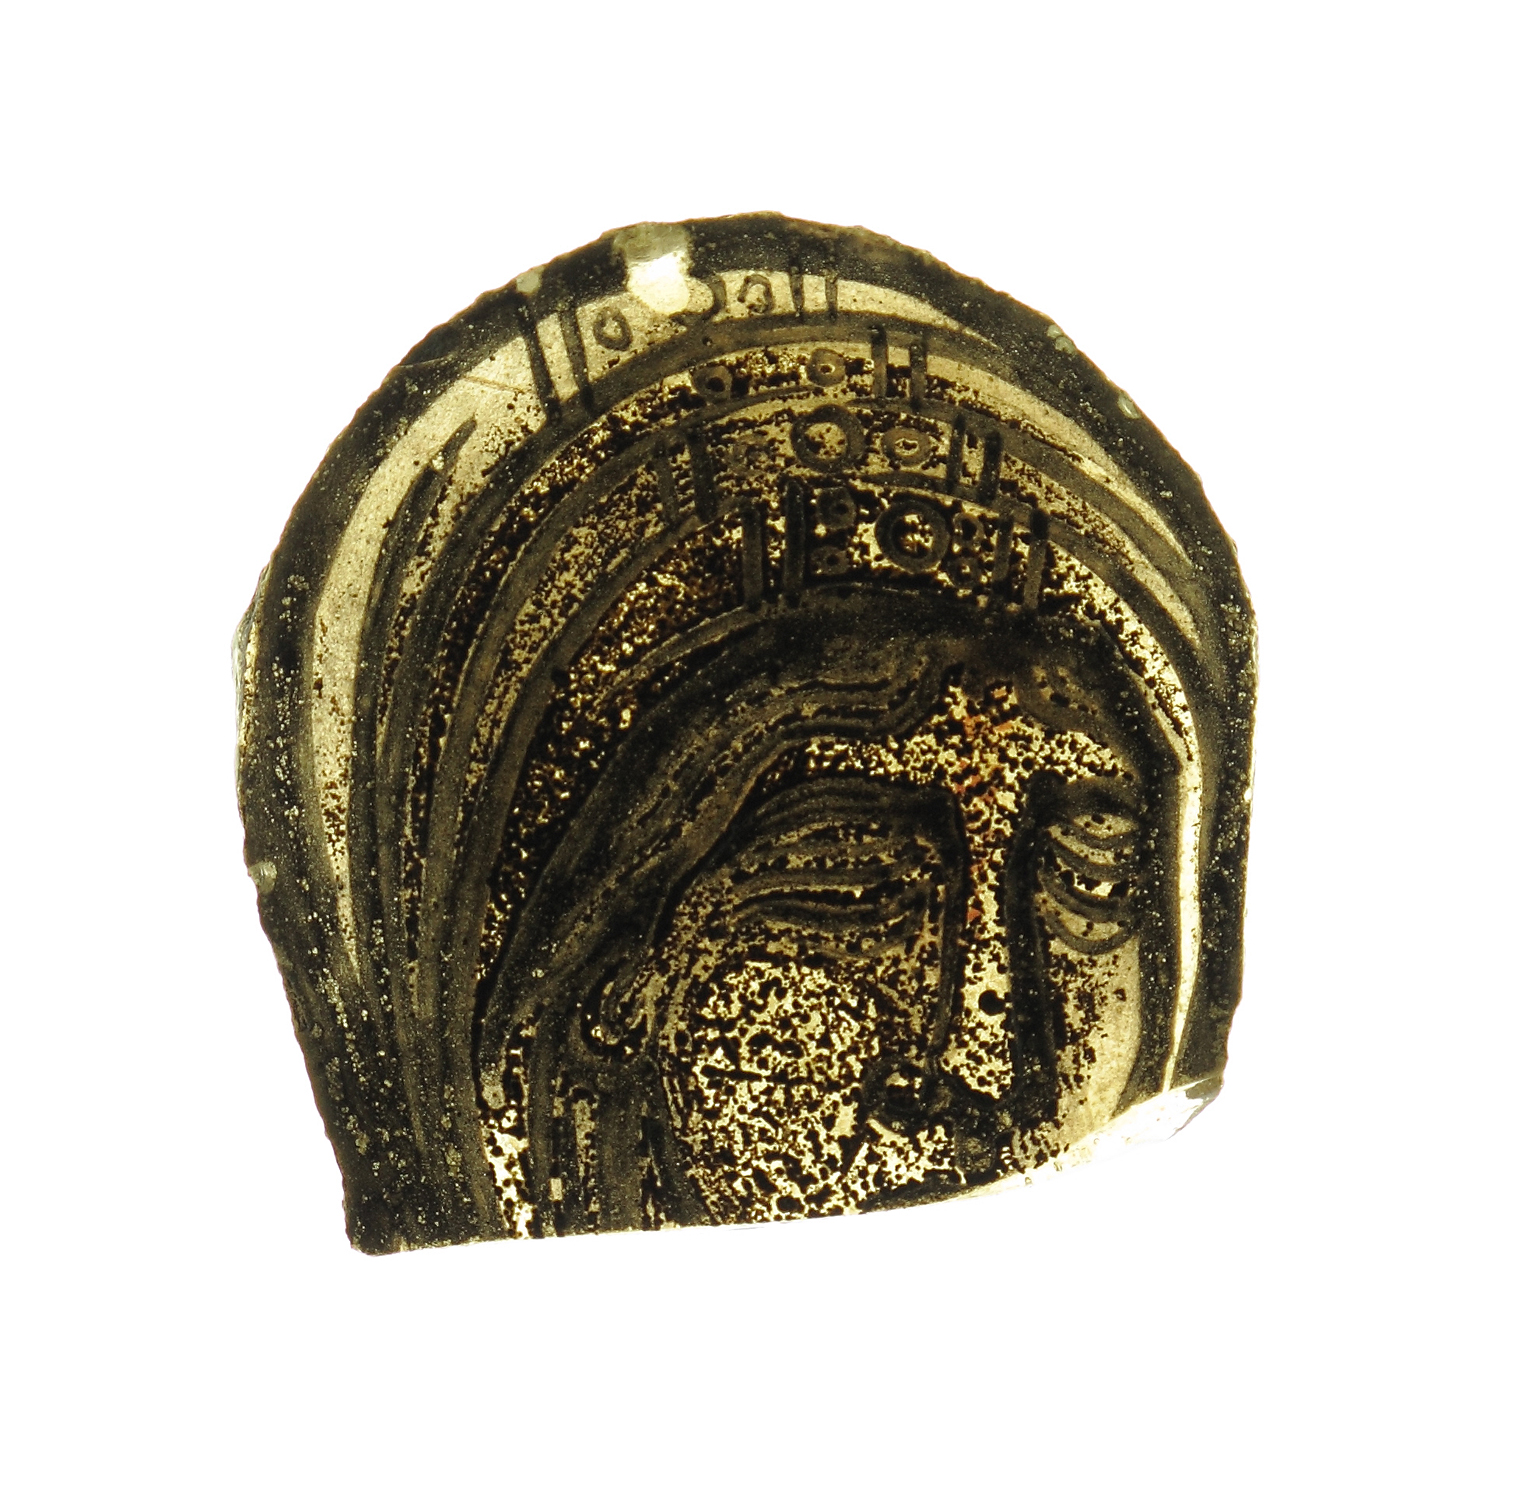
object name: fragment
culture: french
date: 1101-1400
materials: glass, metal, paint